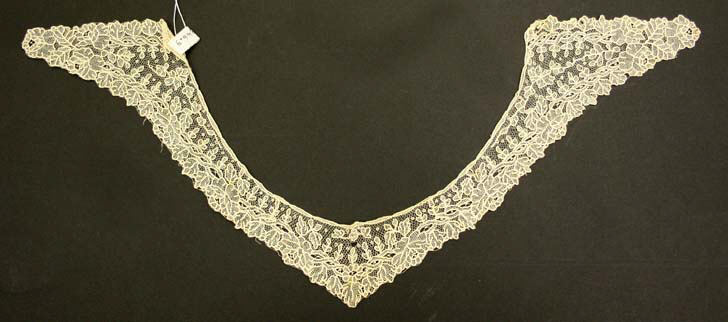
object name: collar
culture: european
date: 1860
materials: cotton